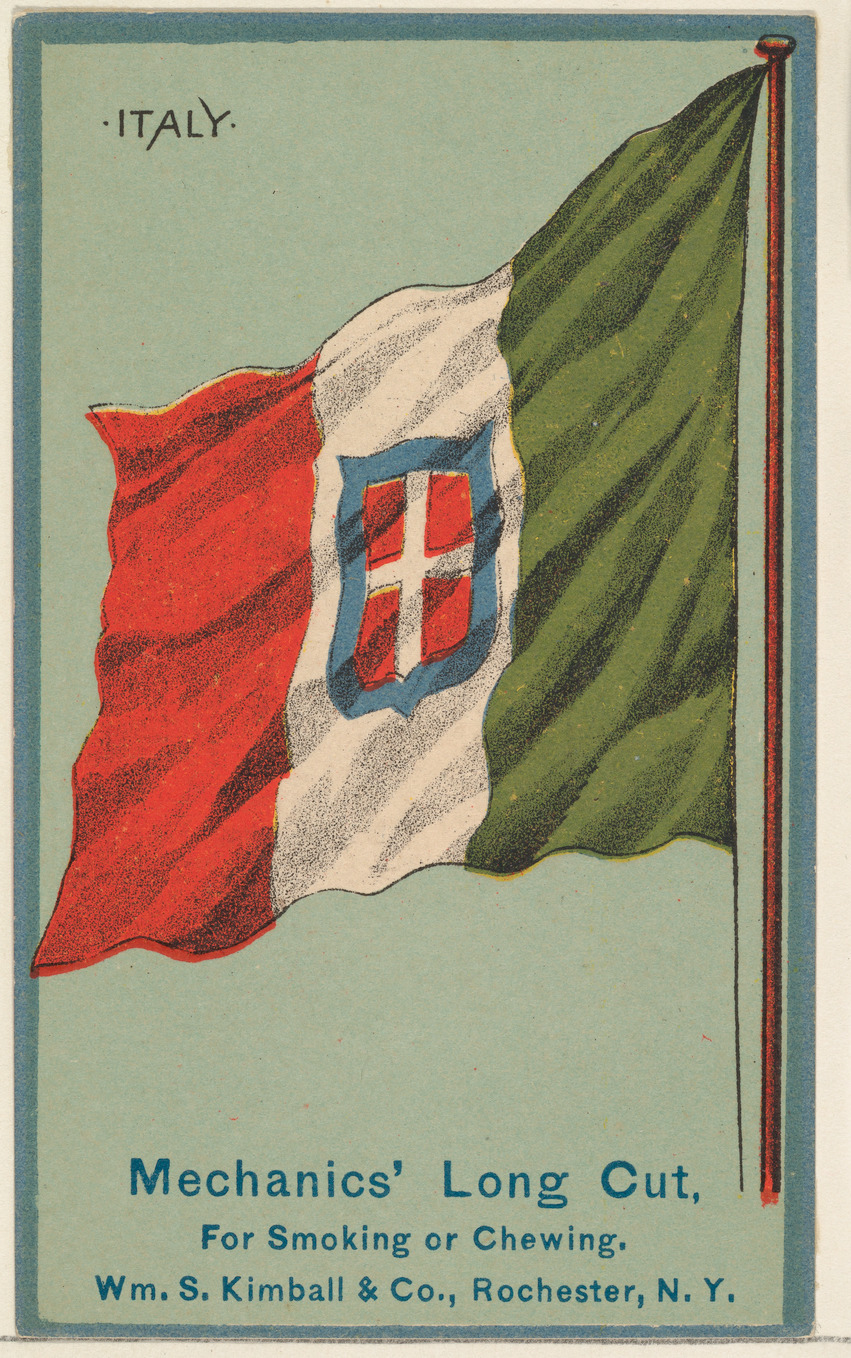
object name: print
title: Italy, from the National Flags series (N195) issued by Wm. S. Kimball & Co.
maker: william s. kimball & company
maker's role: publisher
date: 1891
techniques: color lithograph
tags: flags,insignia